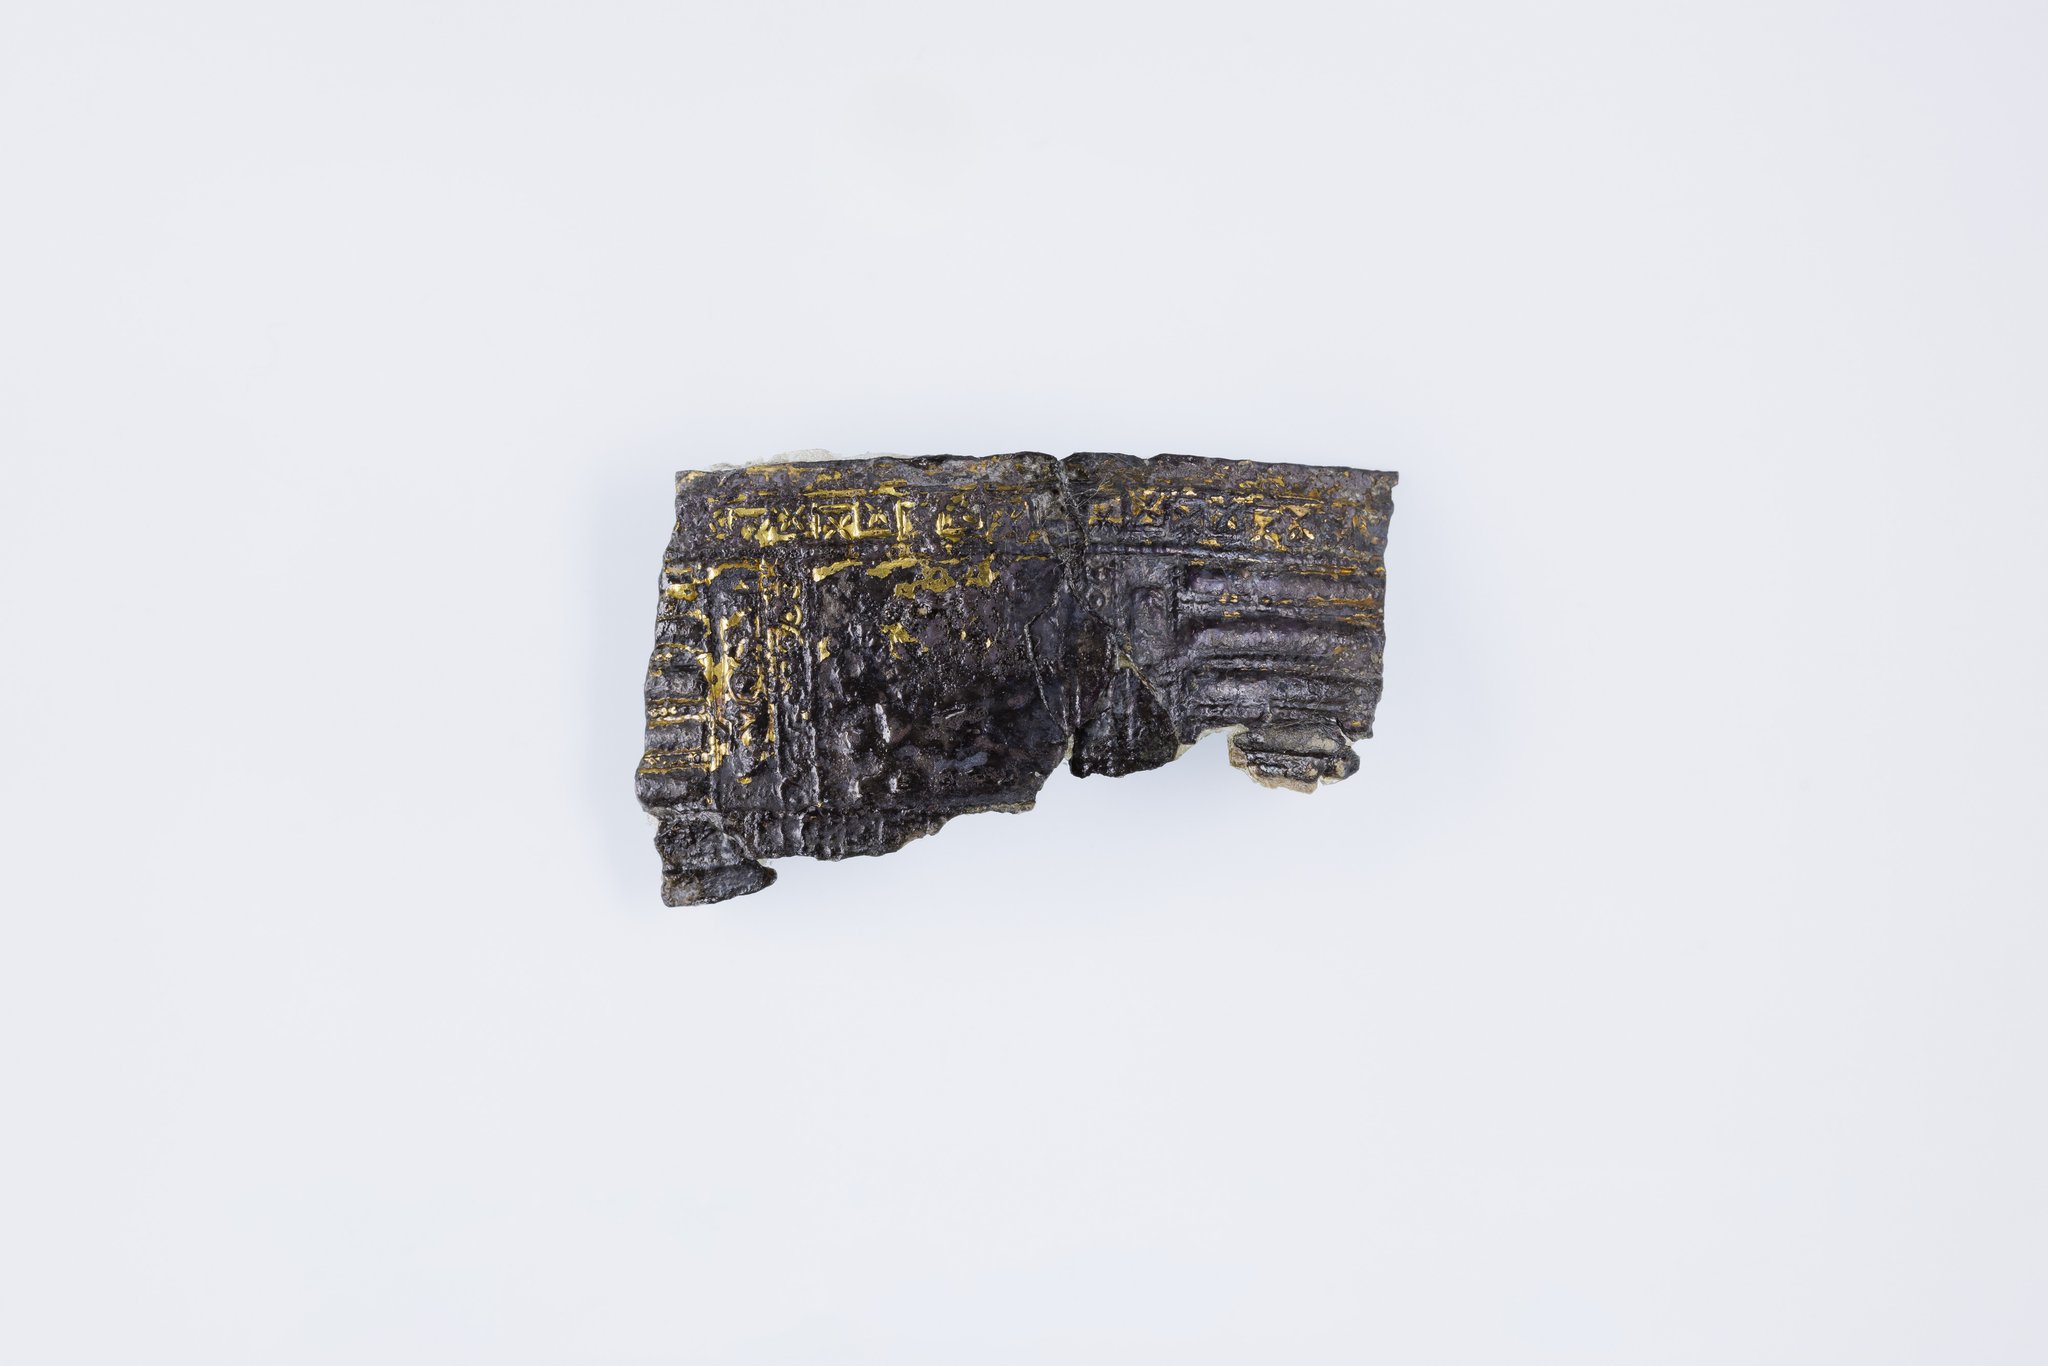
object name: strainer or vase fragment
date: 1295-1070 BCE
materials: silver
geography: egypt